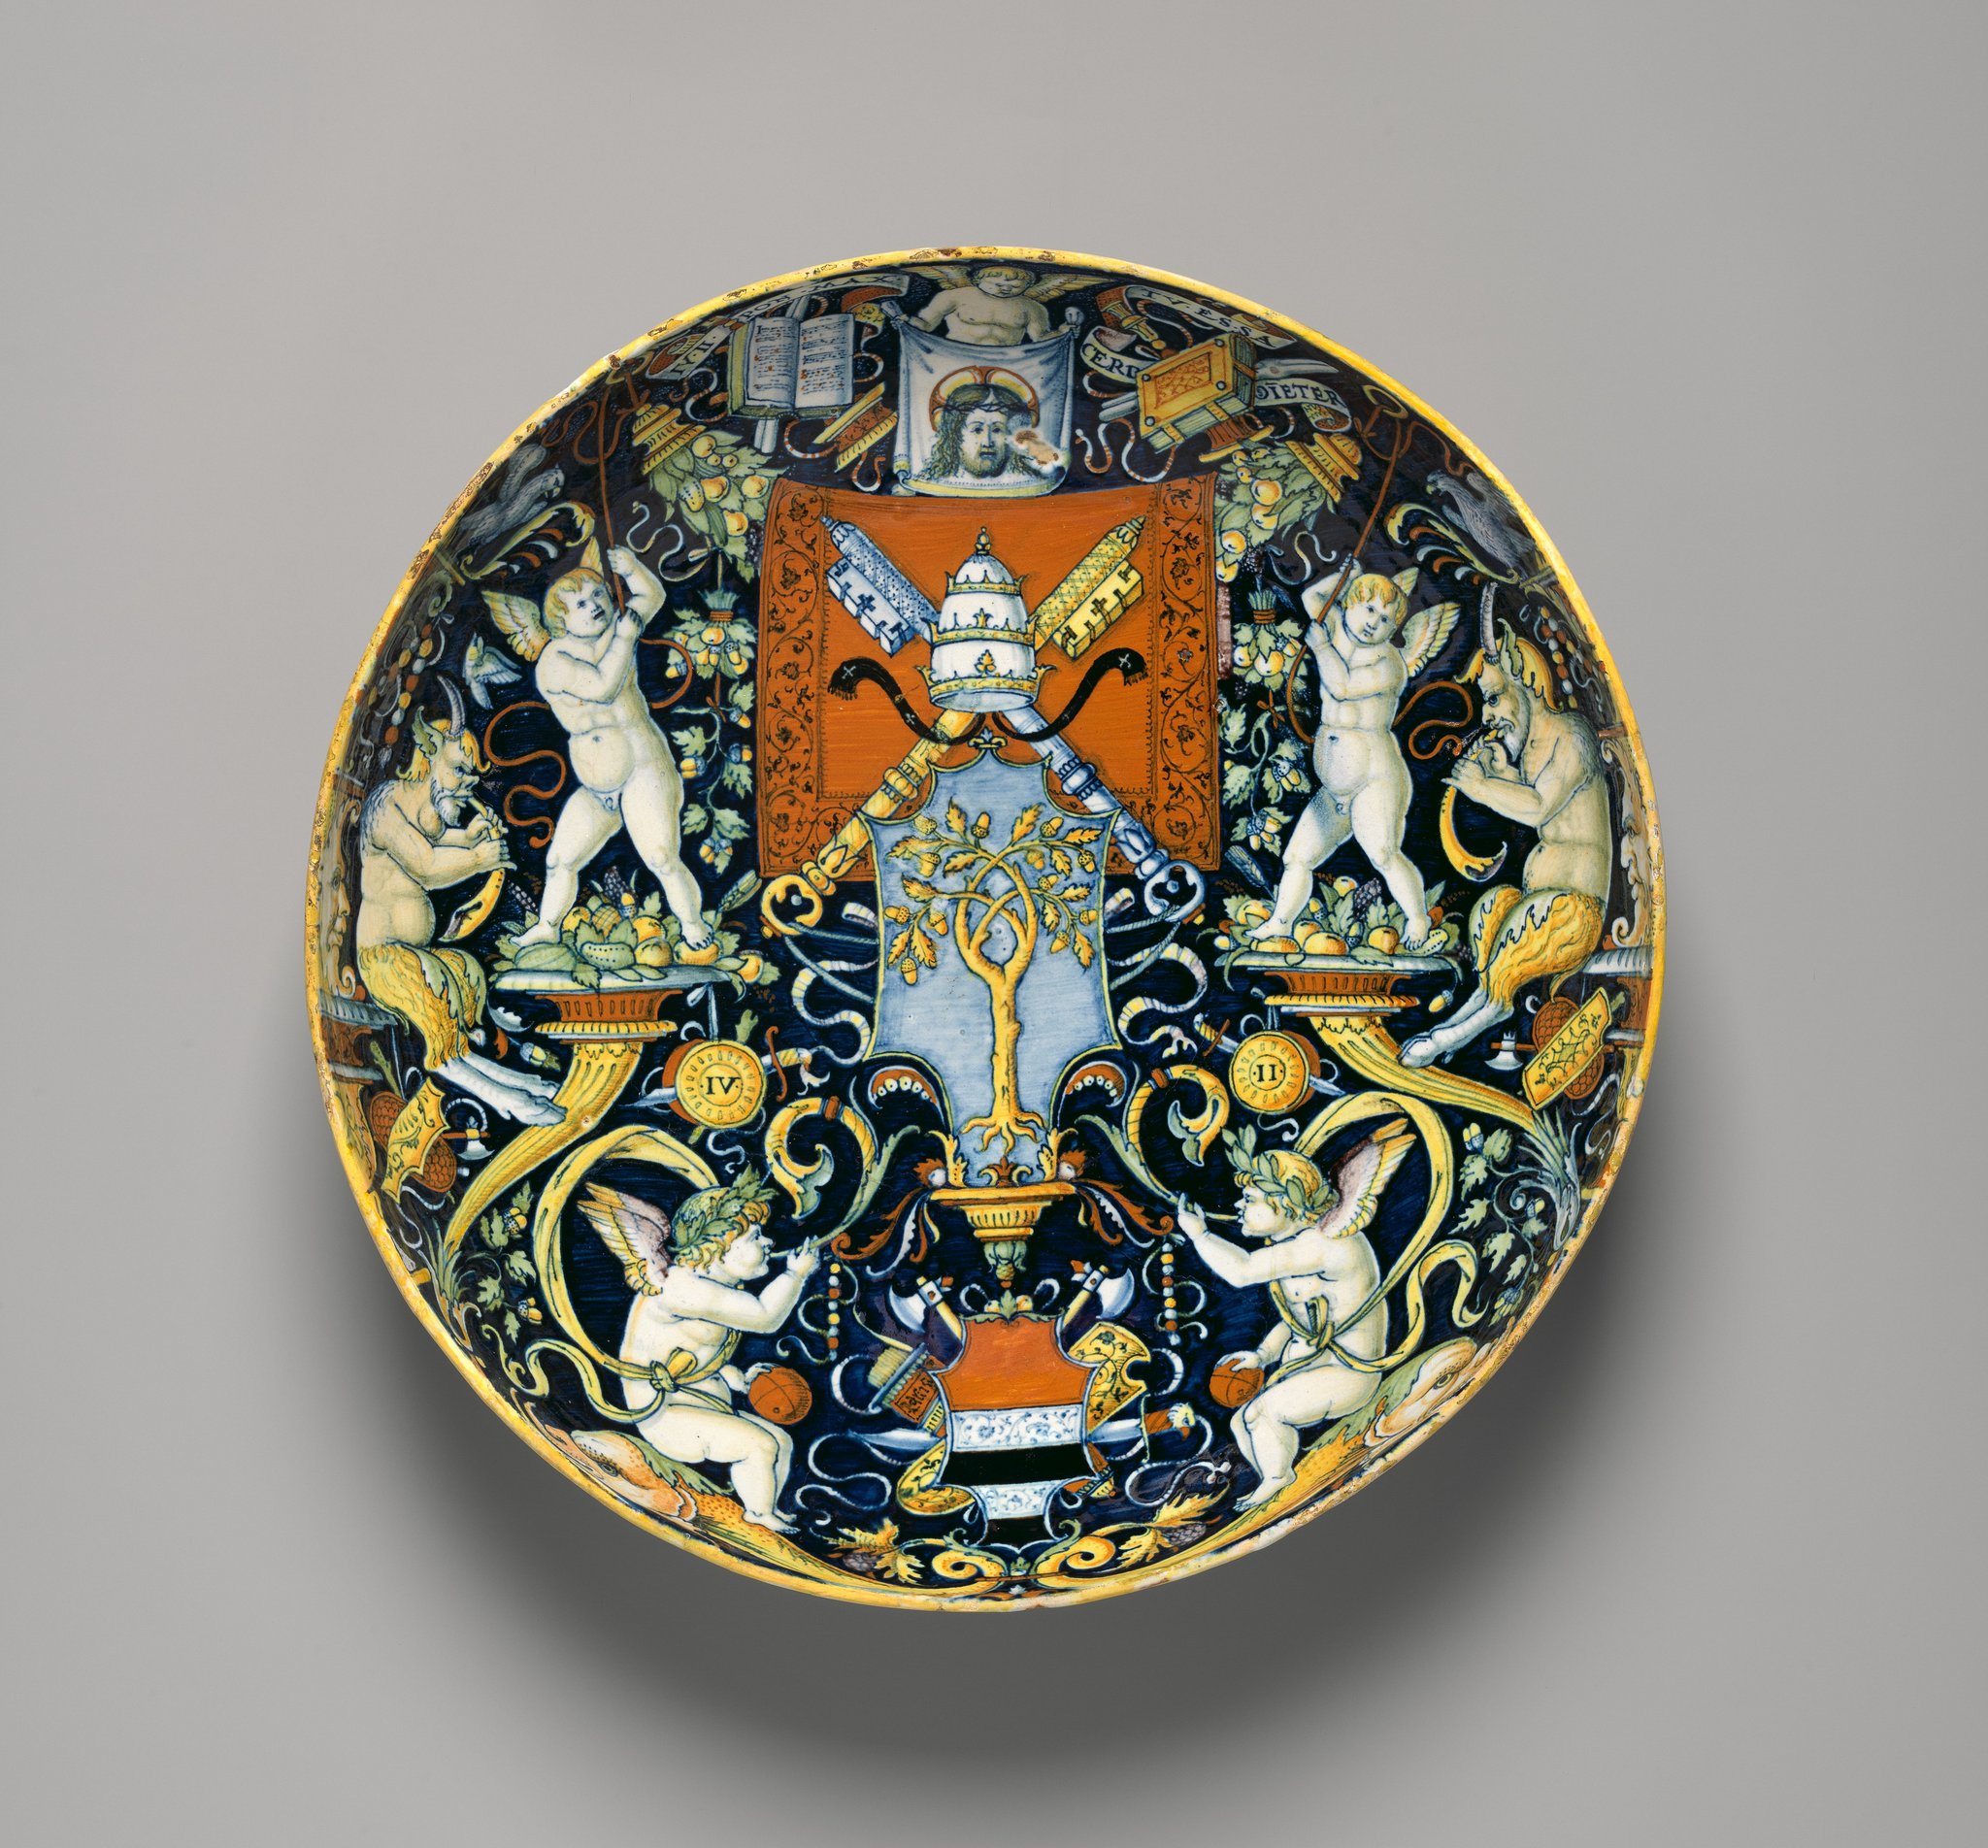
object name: bowl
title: Bowl with the Arms of Pope Julius II and the Manzoli of Bologna surrounded by putti, cornucopiae, satyrs, dolphins, birds, etc.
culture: italian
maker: workshop of giovanni maria vasaro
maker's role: artist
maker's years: 1500-1530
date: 1508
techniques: maiolica, glazing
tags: putti,satyrs,coat of arms